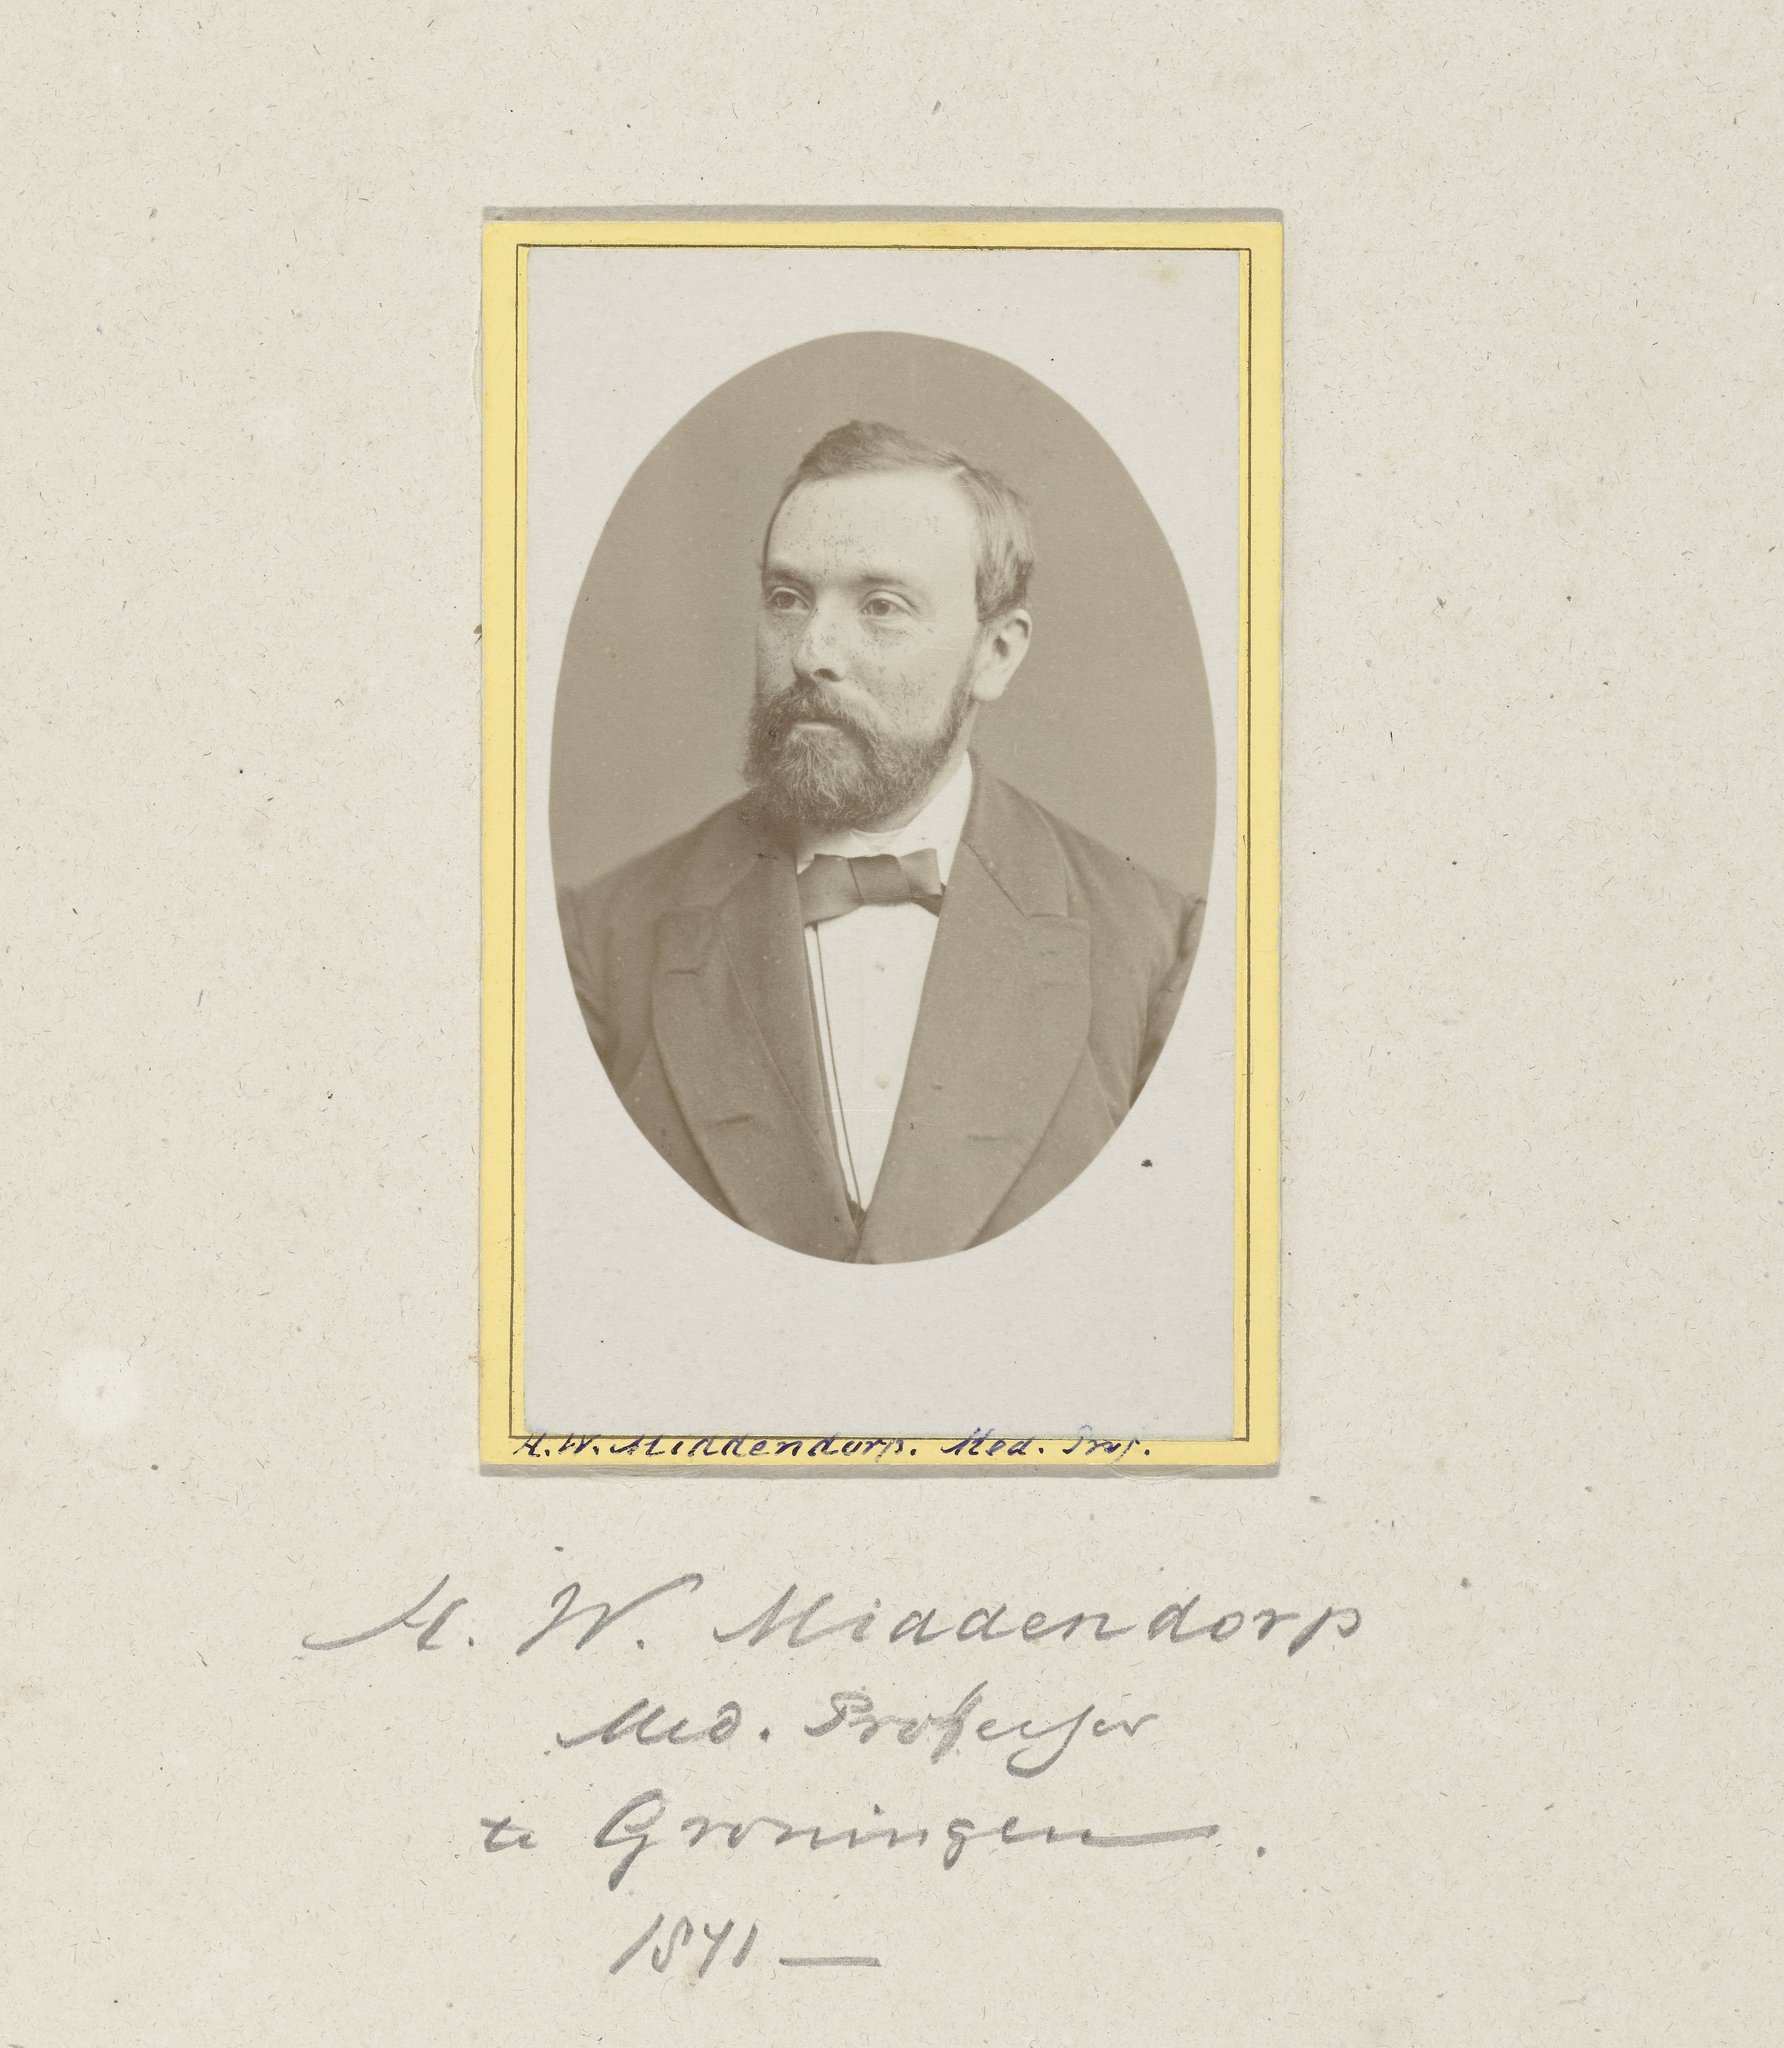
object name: carte de visite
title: Portret van professor H.W. Middendorp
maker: Anonymous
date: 1860-1880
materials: paper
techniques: albumen print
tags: historical persons (portraits and scenes from the life)